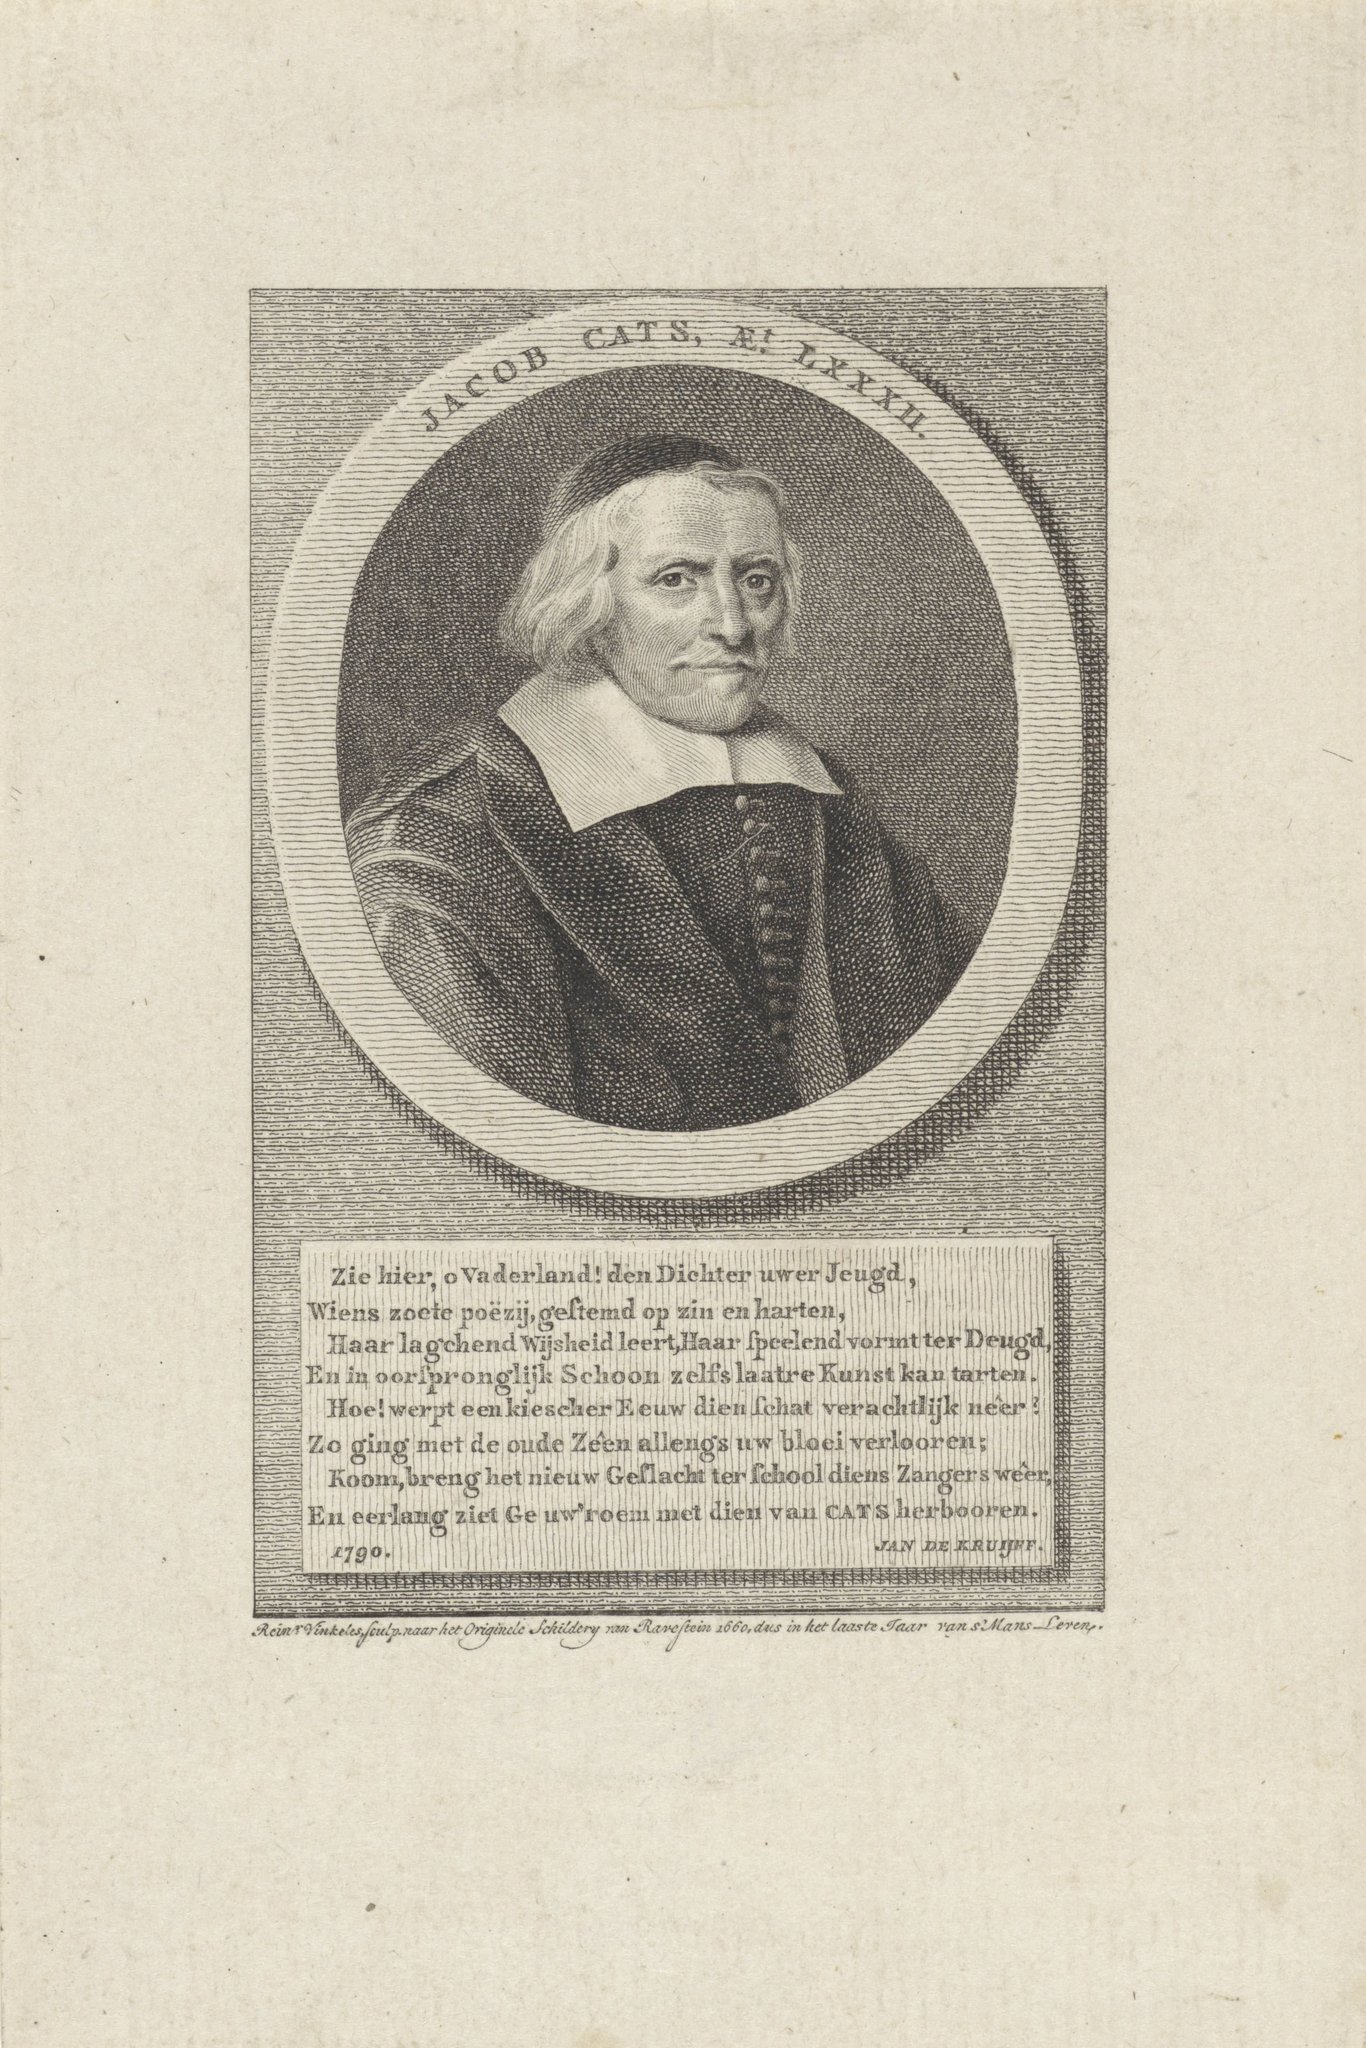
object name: print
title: Portret van Jacob Cats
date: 1751-1816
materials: paper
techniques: engraving, etching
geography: amsterdam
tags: jacob cats (1577-1660), historical persons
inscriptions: collector's mark: Lugt 2228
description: Portret van de staatsman en dichter Jacob Cats op 82-jarige leeftijd.